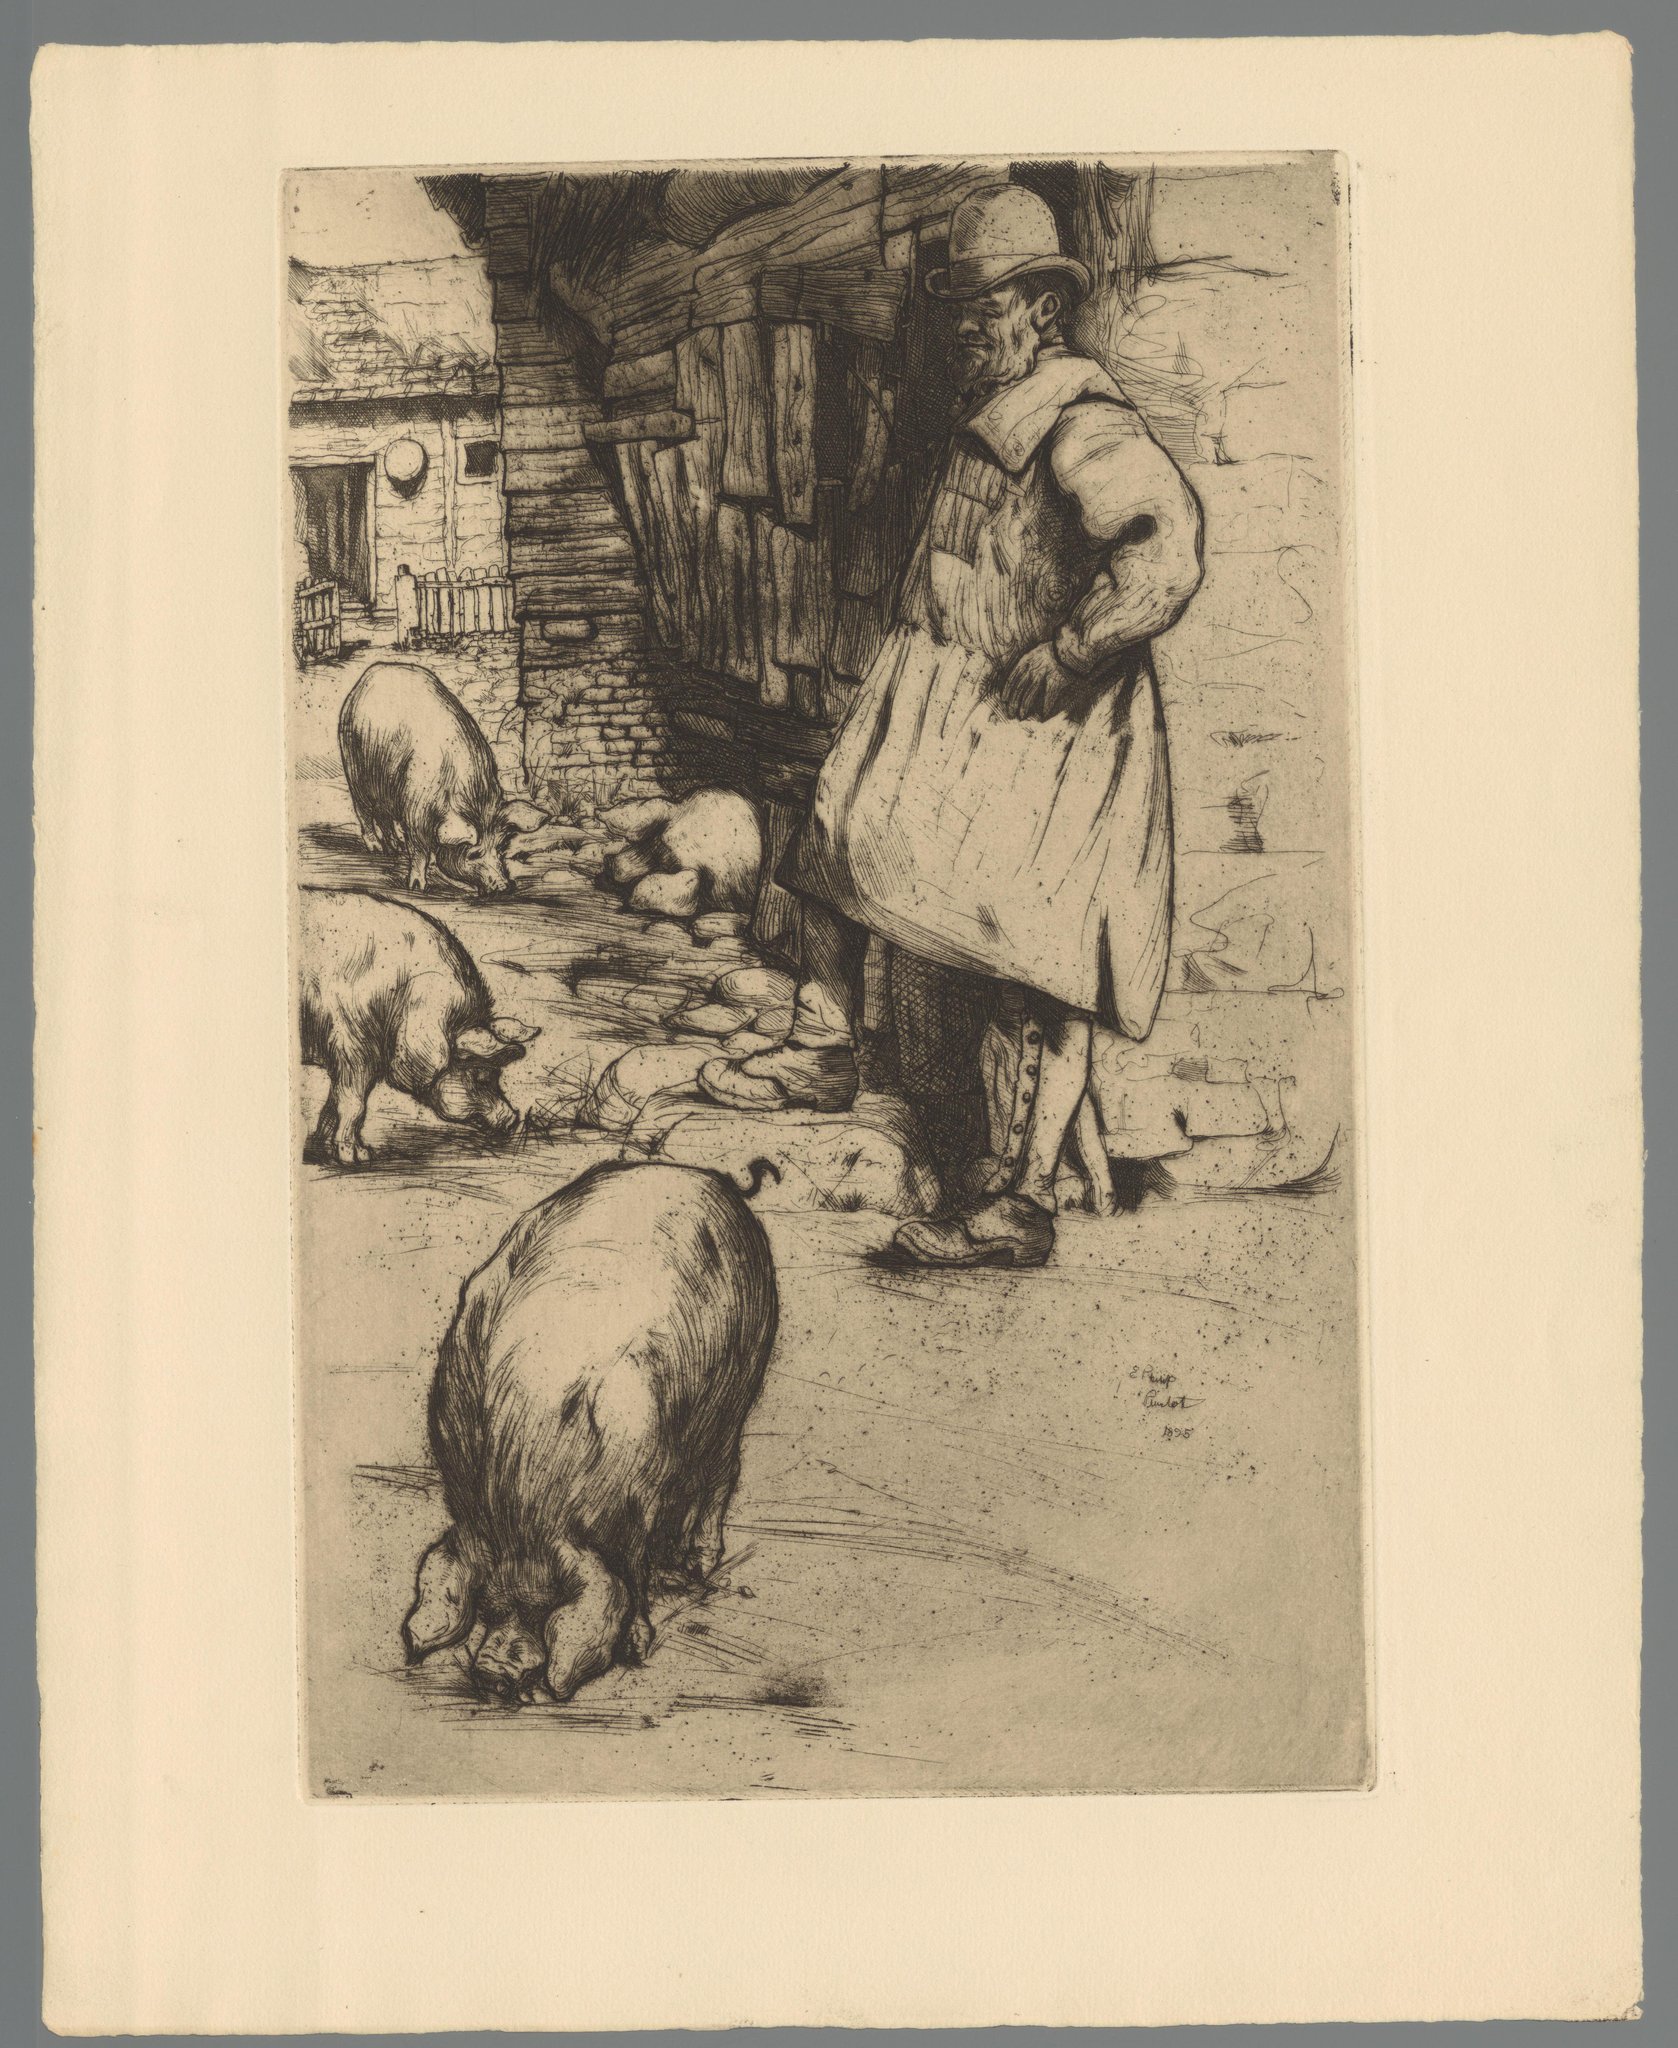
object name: print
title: The Farmer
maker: philip pimlott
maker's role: print maker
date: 1895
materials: paper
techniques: drypoint, etching, intaglio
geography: london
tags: pig, farmers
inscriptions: collector's mark: Lugt 2228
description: Prent uit: The Artist Engraver: A Quarterly Magazine of Original Work, 1904. De prent zit in een omslag van blauw papier.